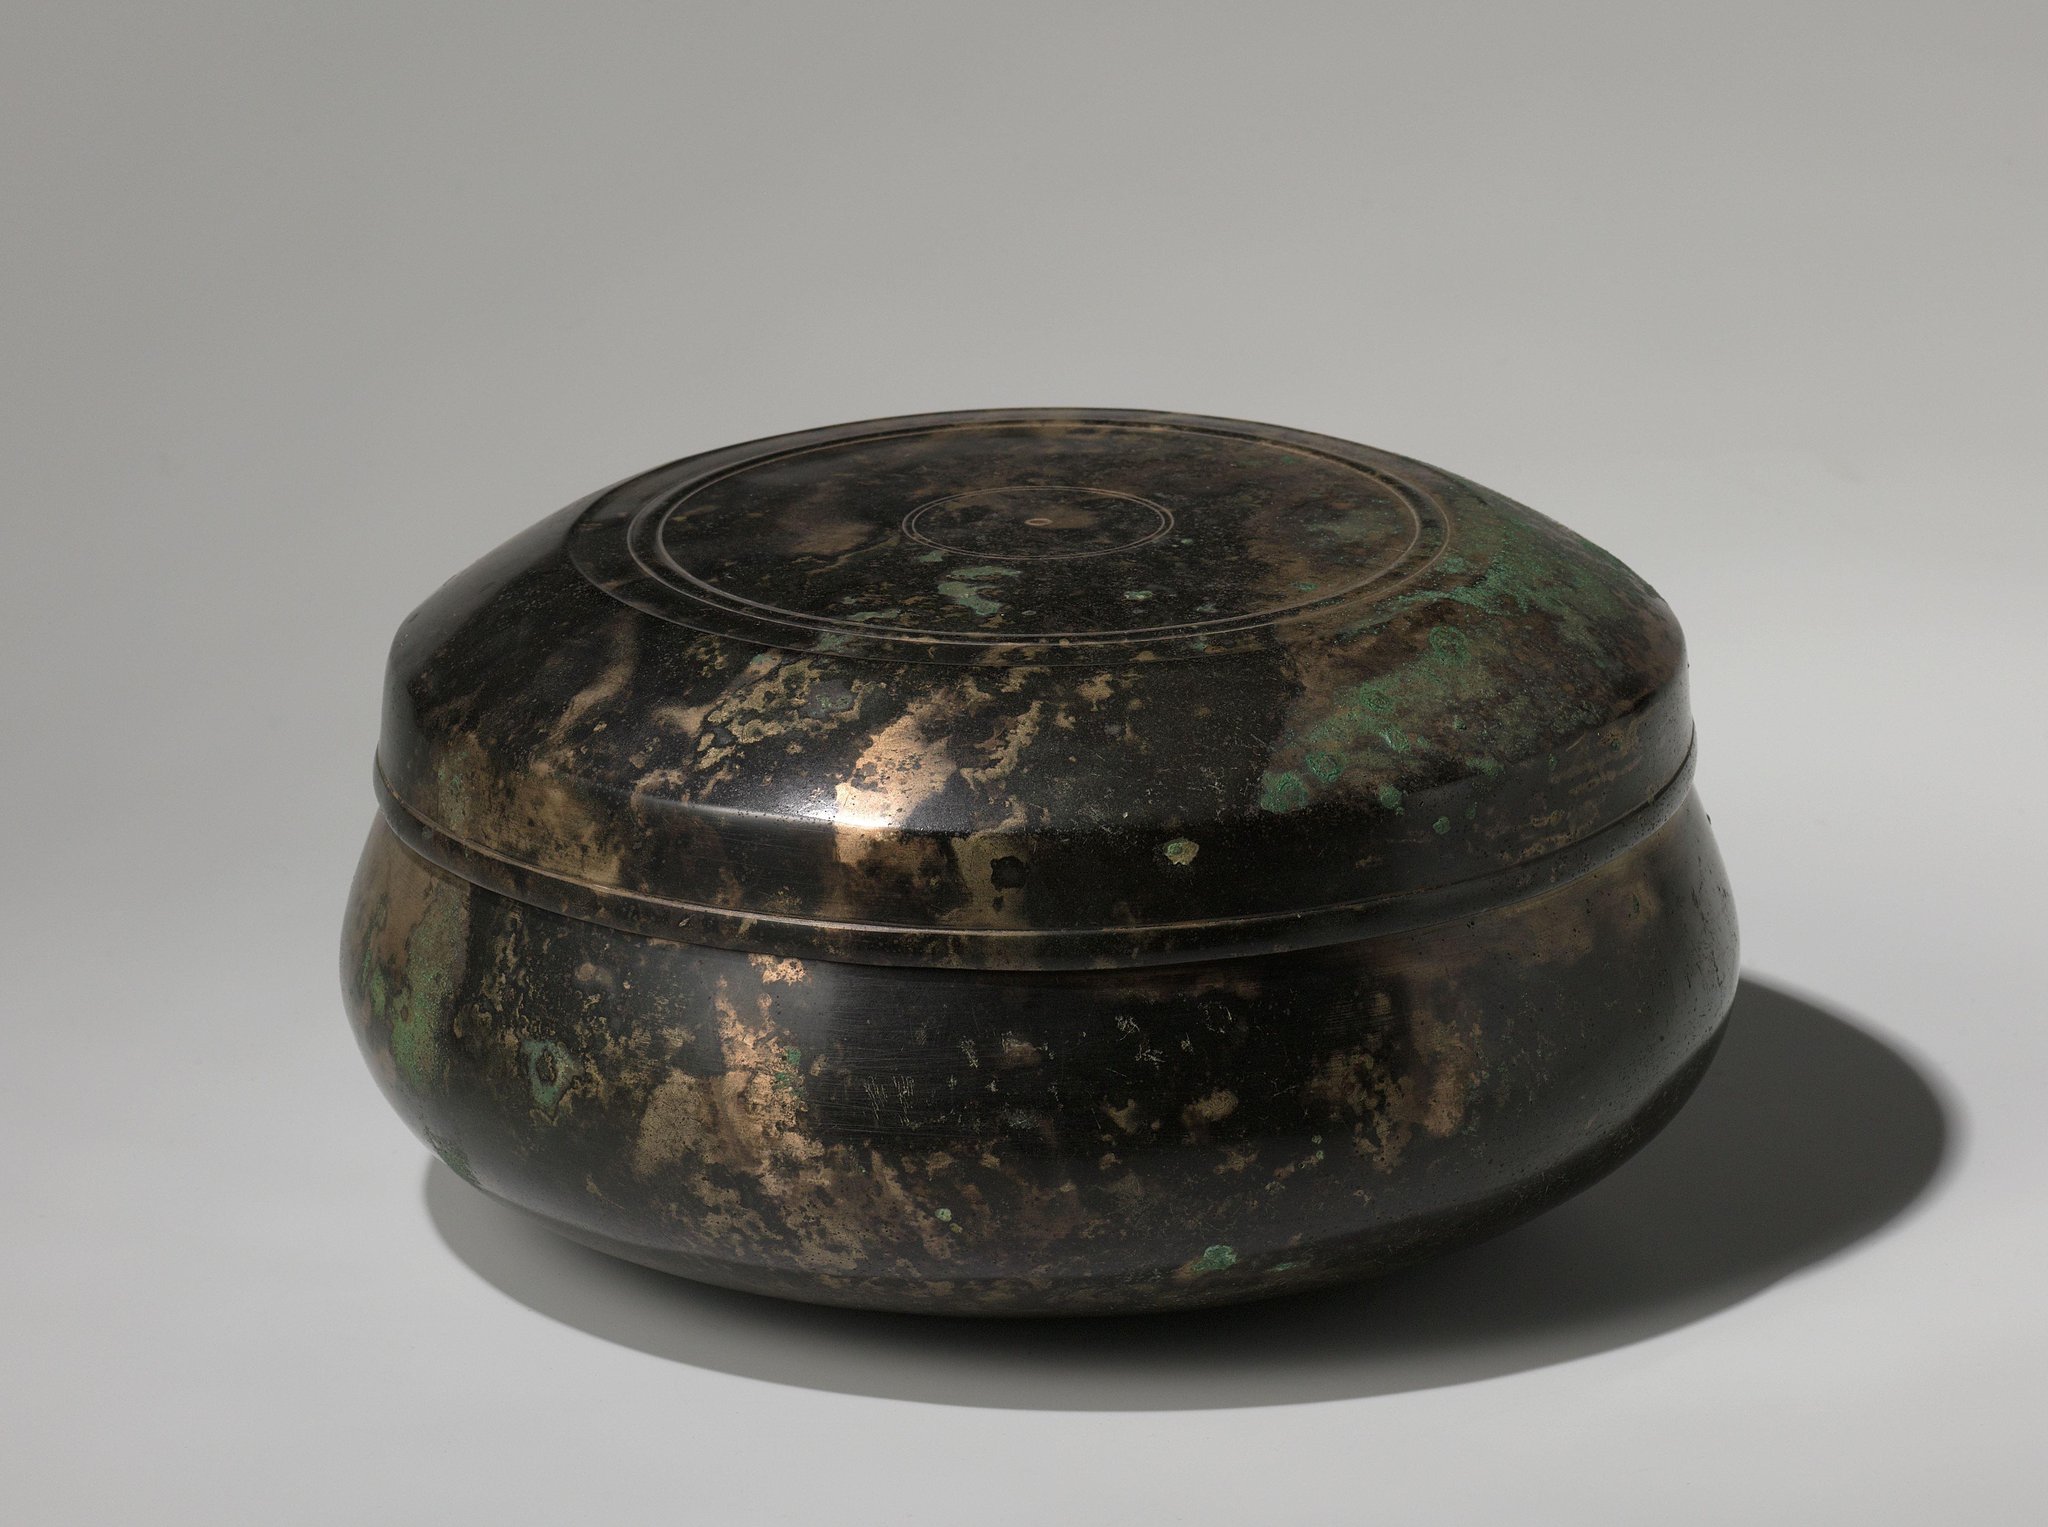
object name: box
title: Lidded box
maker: Anonymous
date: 1200-1500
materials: bronze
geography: korea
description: During this period (c. 1200-1500) many bronze objects played a role in Korean Buddhist rituals, underlining the importance of Buddhism in Korea. However, small boxes like this one served a secular purpose. They have been found in tombs, alongside stoneware and other items intended for the afterlife of the deceased.